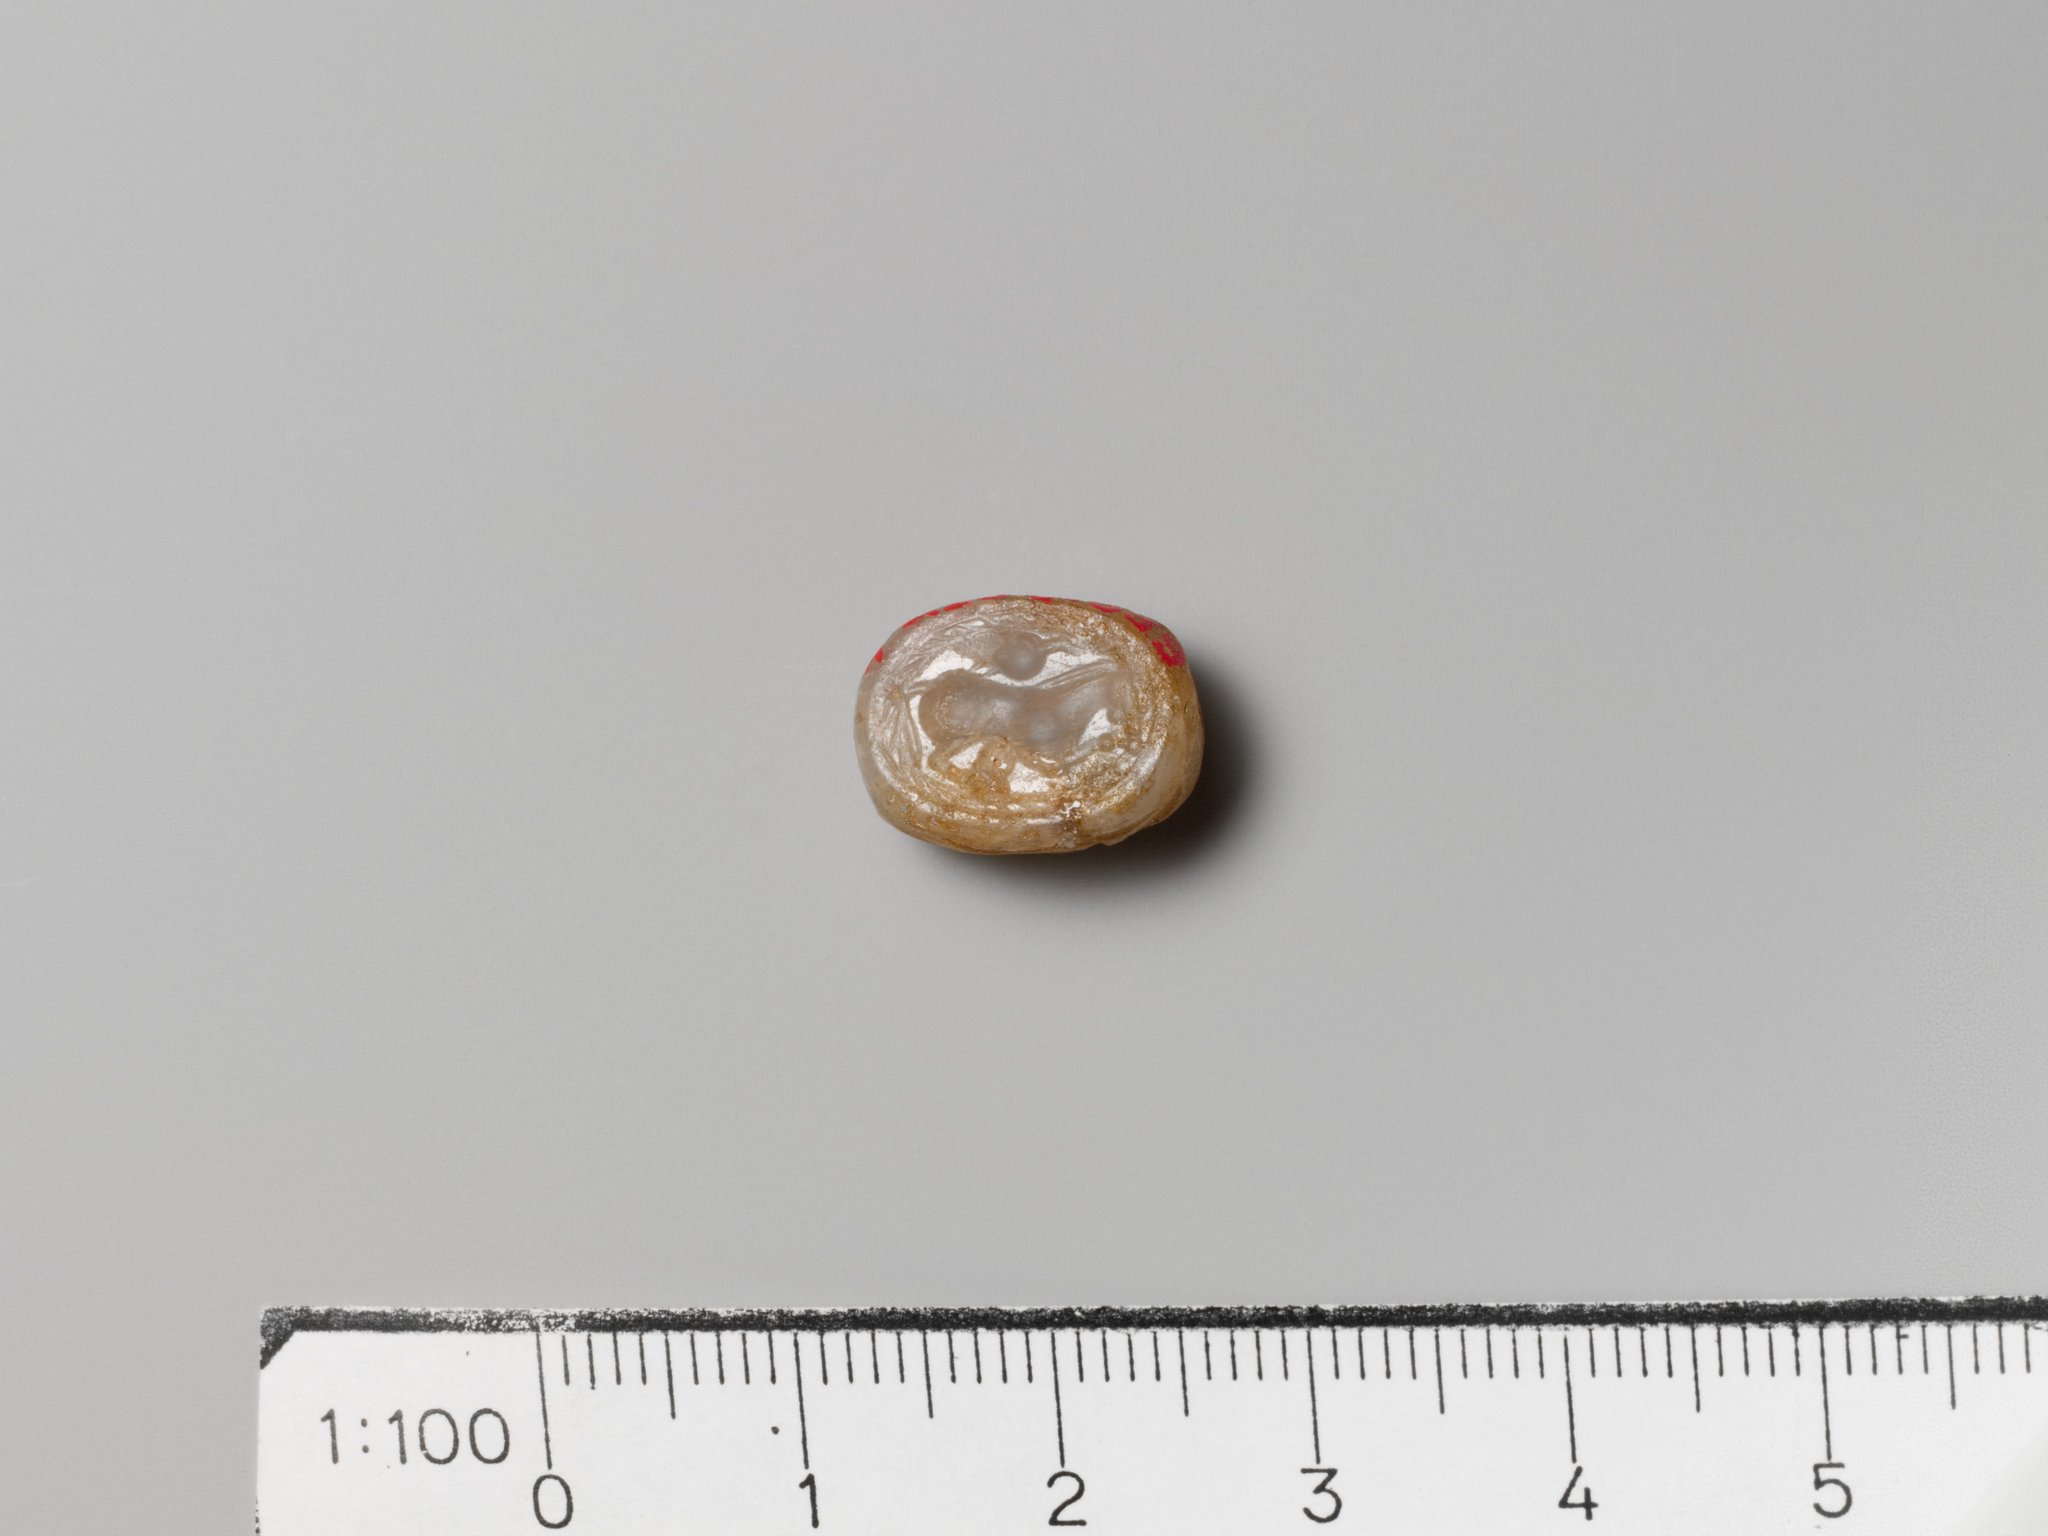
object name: scarab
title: Chalcedony scarab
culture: etruscan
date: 400-301 BCE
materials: stone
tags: birds,horses,scarabs